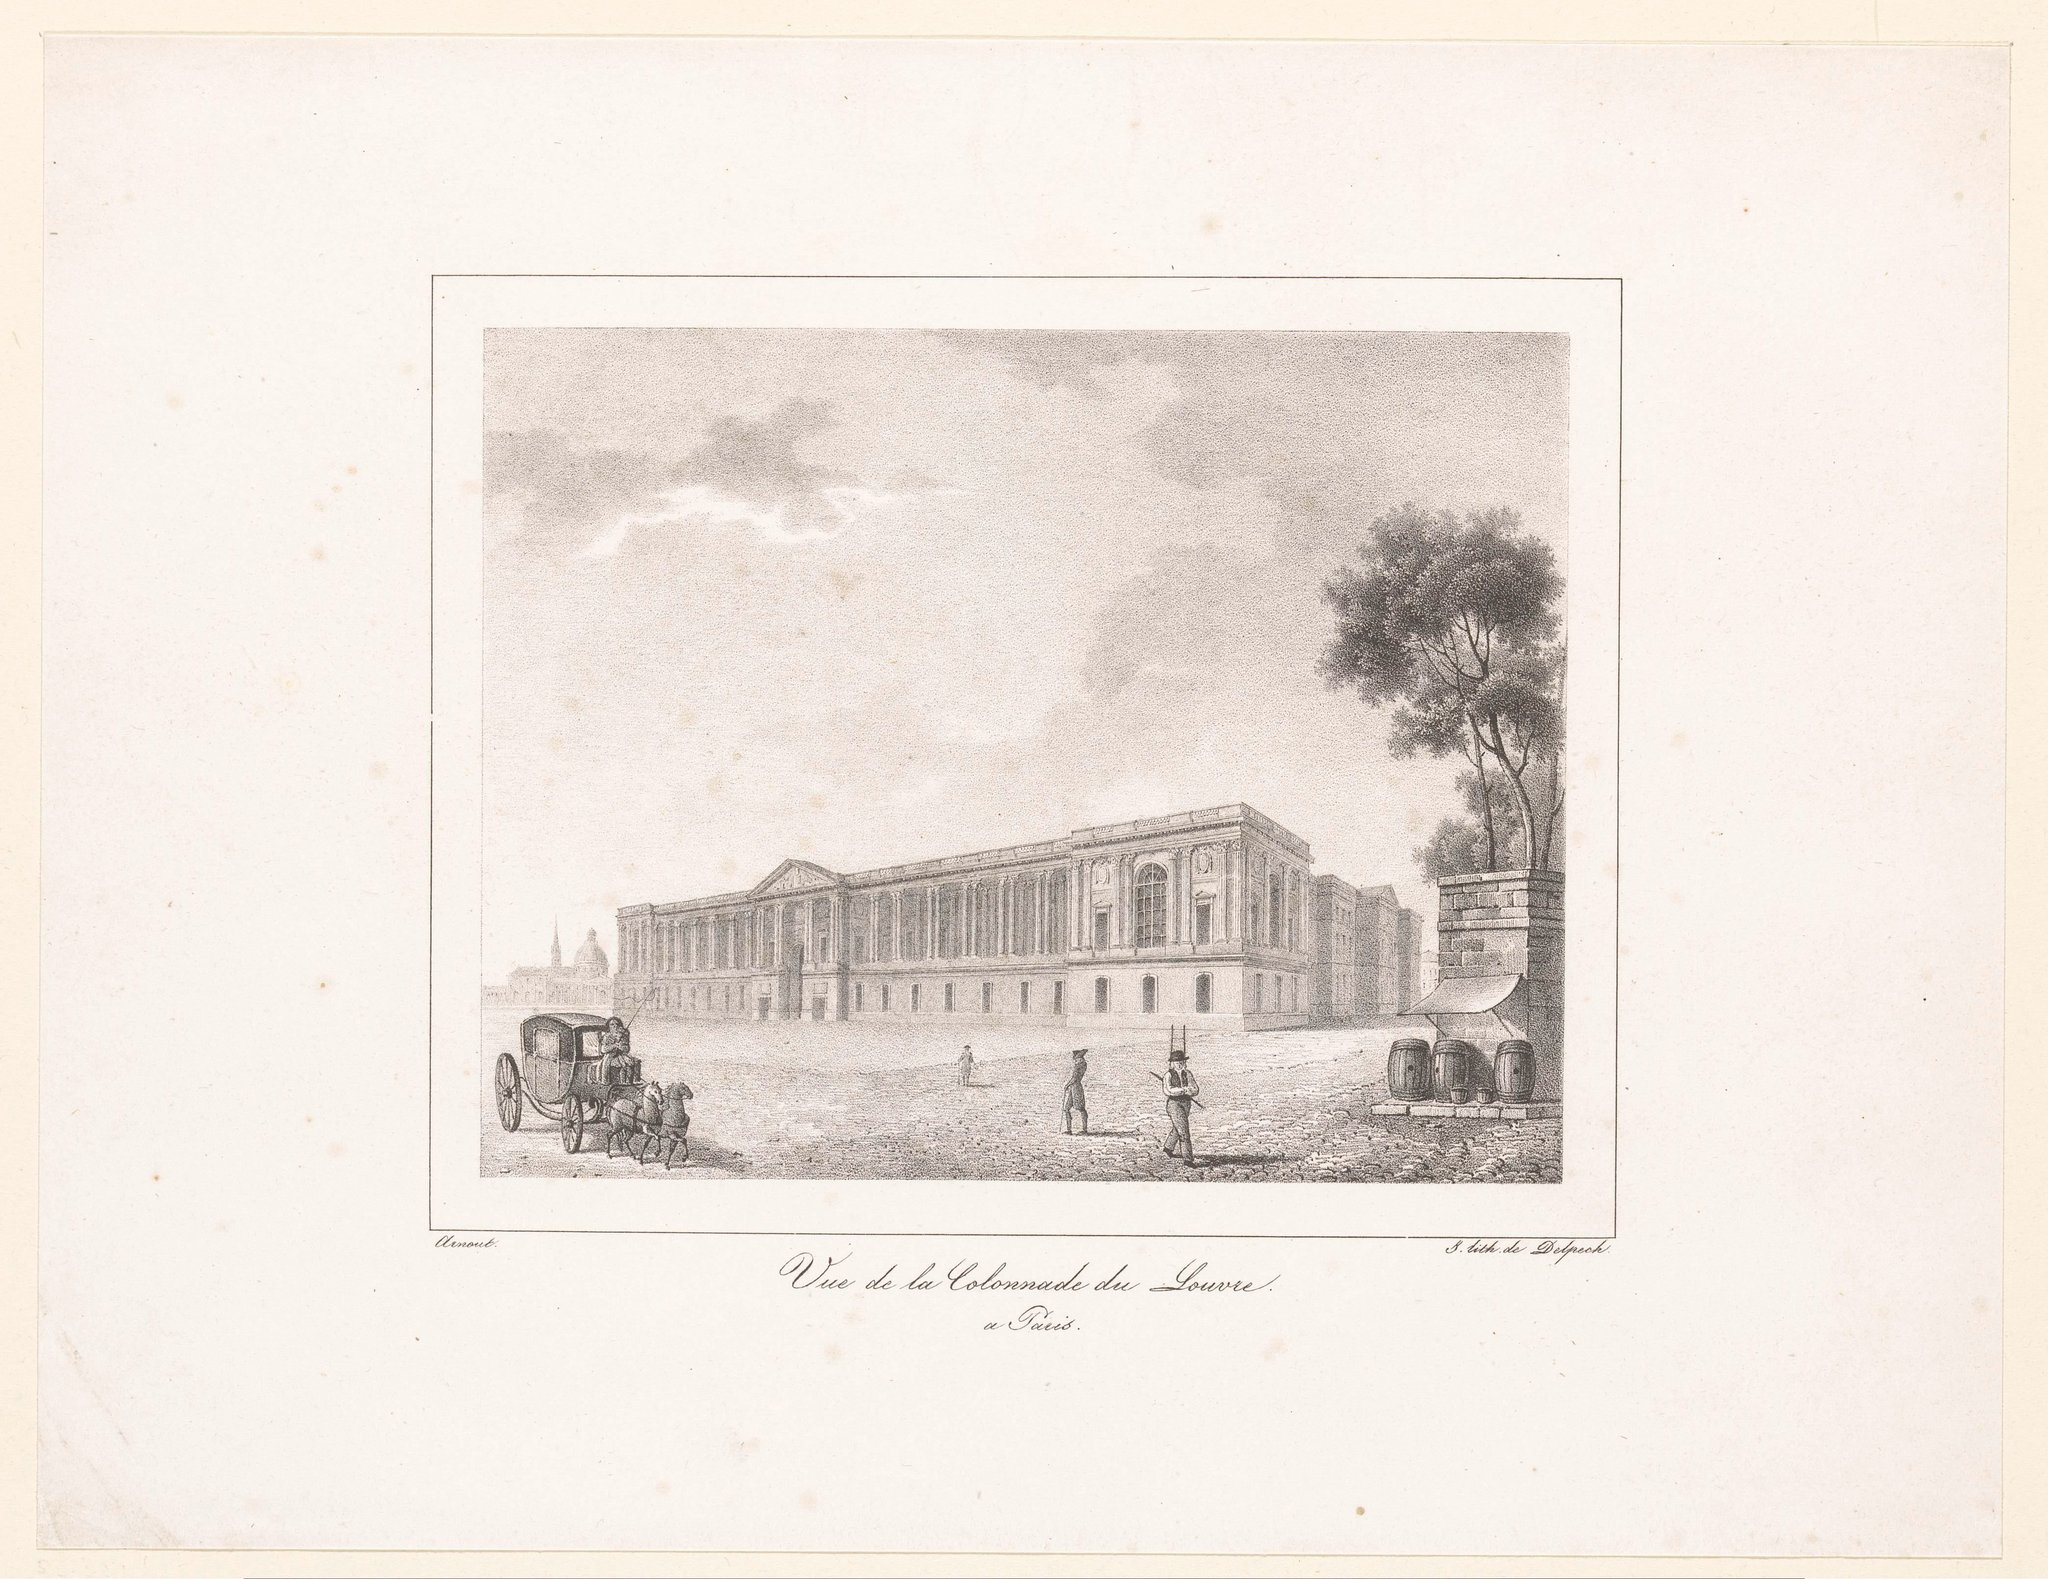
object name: print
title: Vue de la colonnade du Louvre à Paris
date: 1820-1821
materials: paper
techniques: lithograph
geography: paris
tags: colonnade, palace, paris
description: De serie waar deze prent deel van uit maakt, bestaat waarschijnlijk uit dertig prenten.